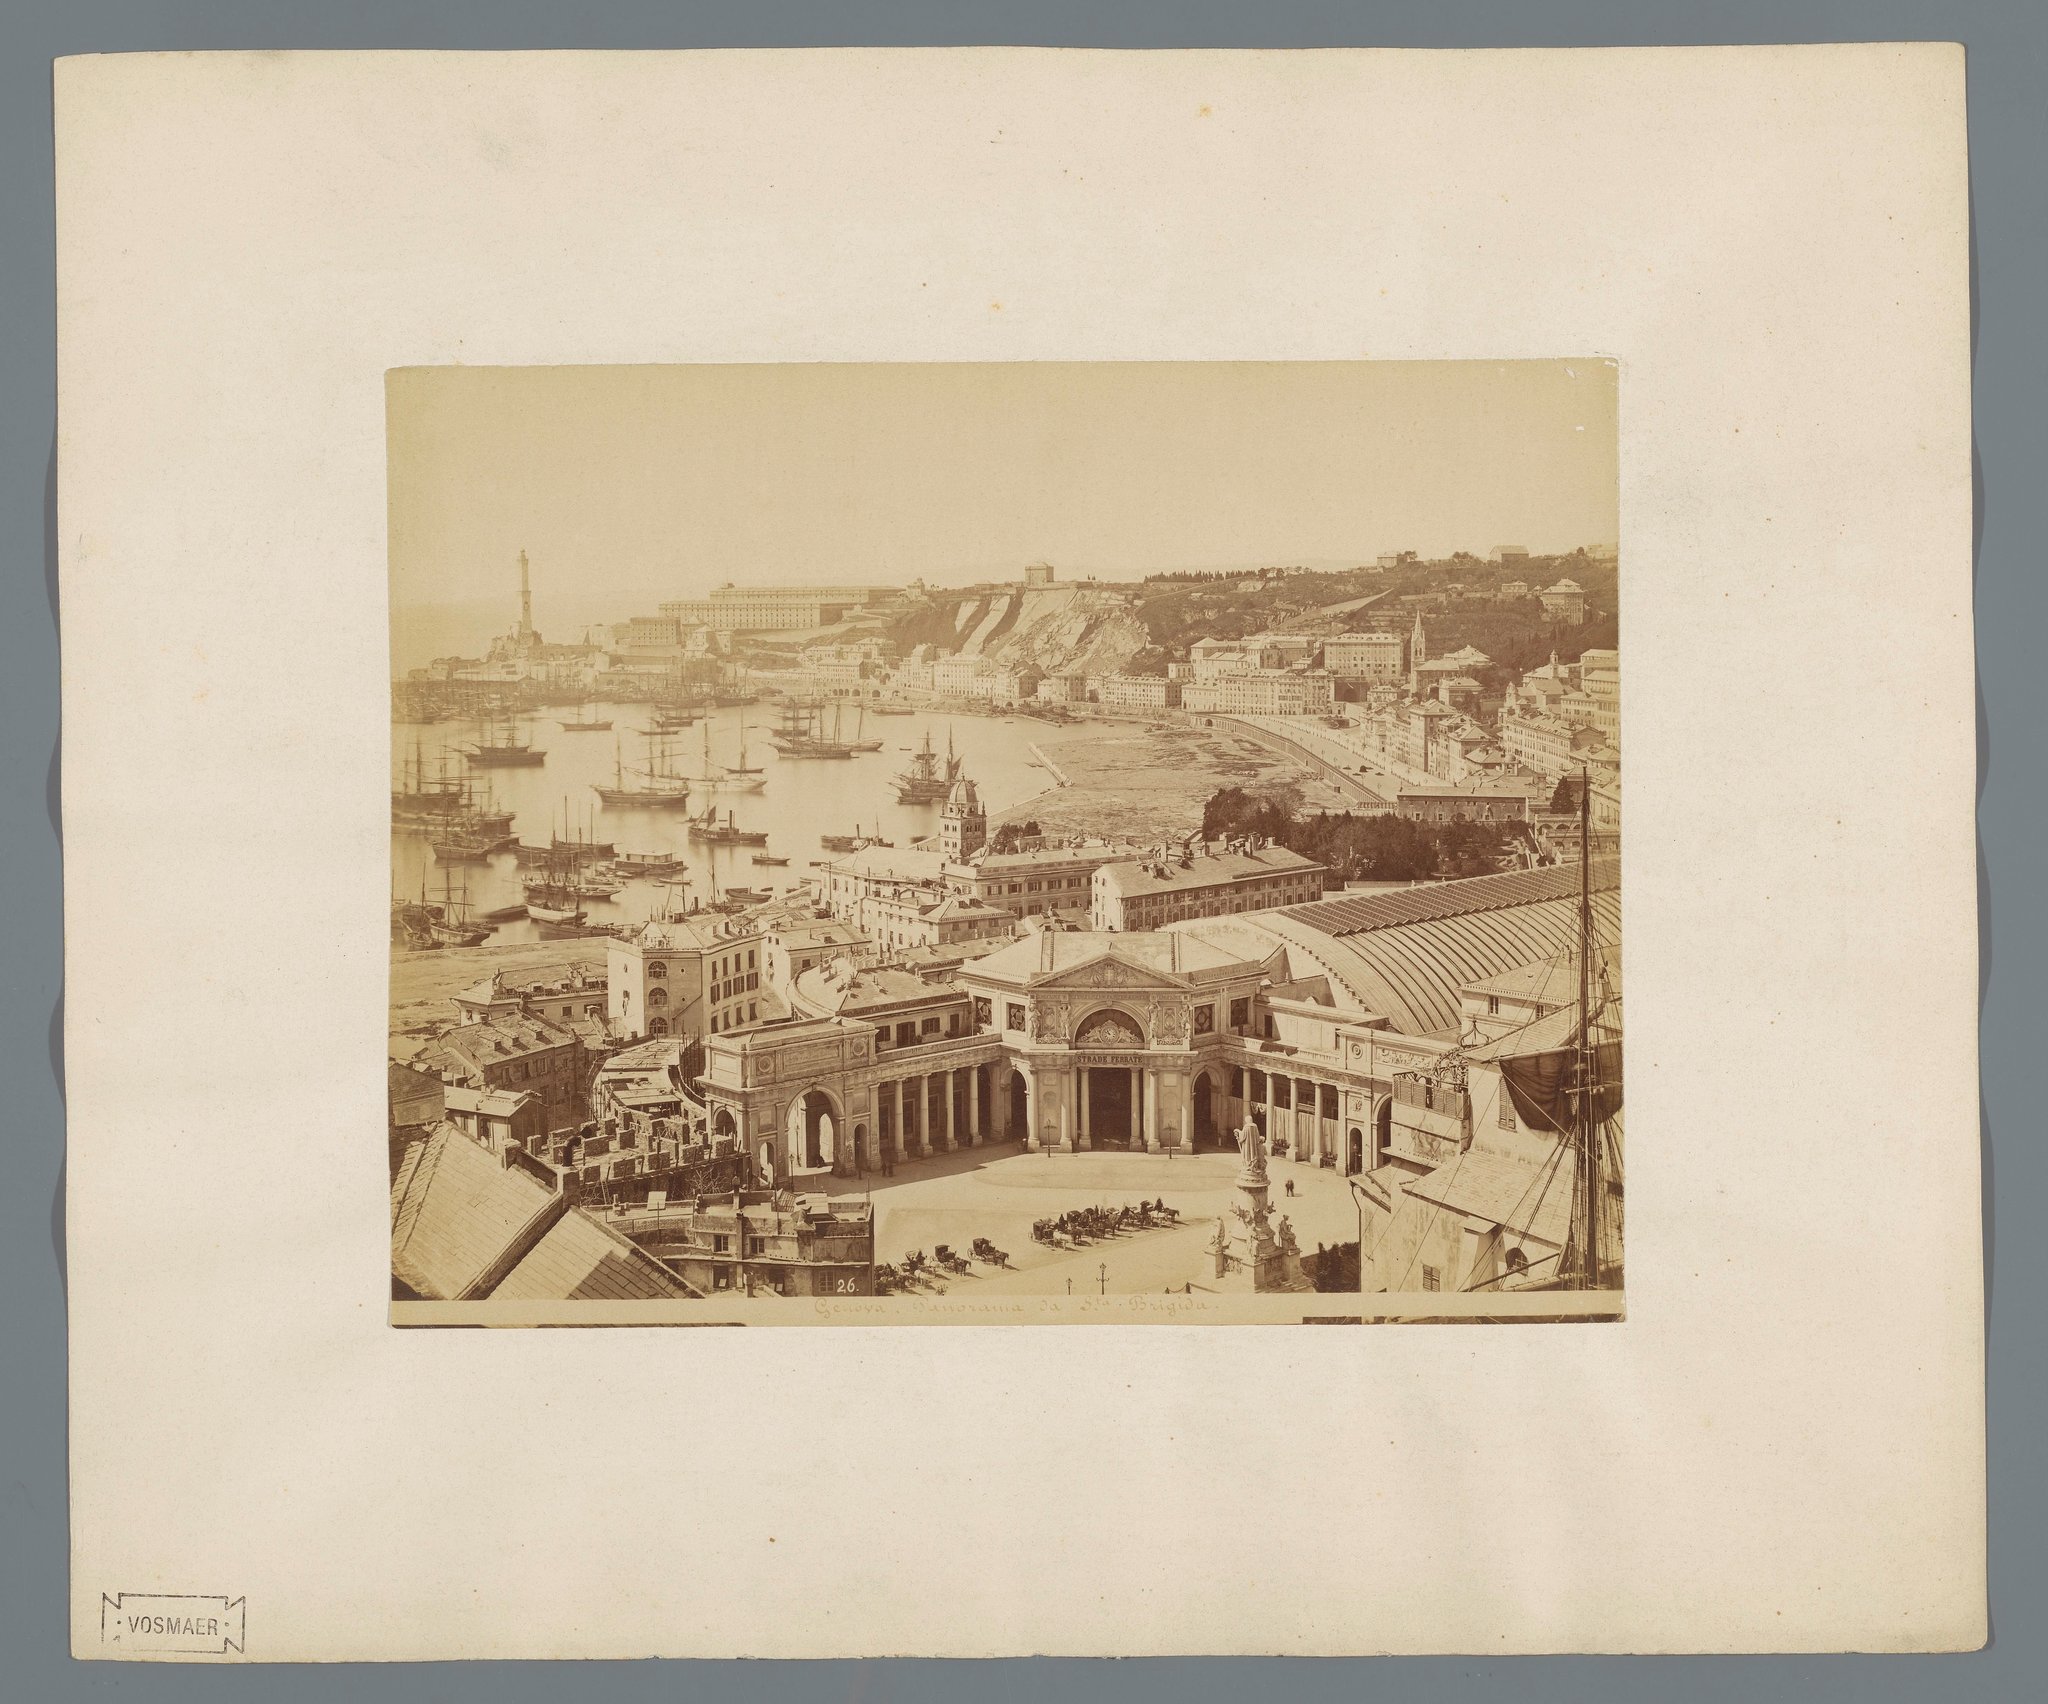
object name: stereograph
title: Gezicht op Parijs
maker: Anonymous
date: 1850-1880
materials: cardboard, photographic support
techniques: albumen print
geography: paris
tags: paris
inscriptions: inscription: ‘Montmartre St Eustache Tour St. Jacques [...]’, number: ‘No. 55’